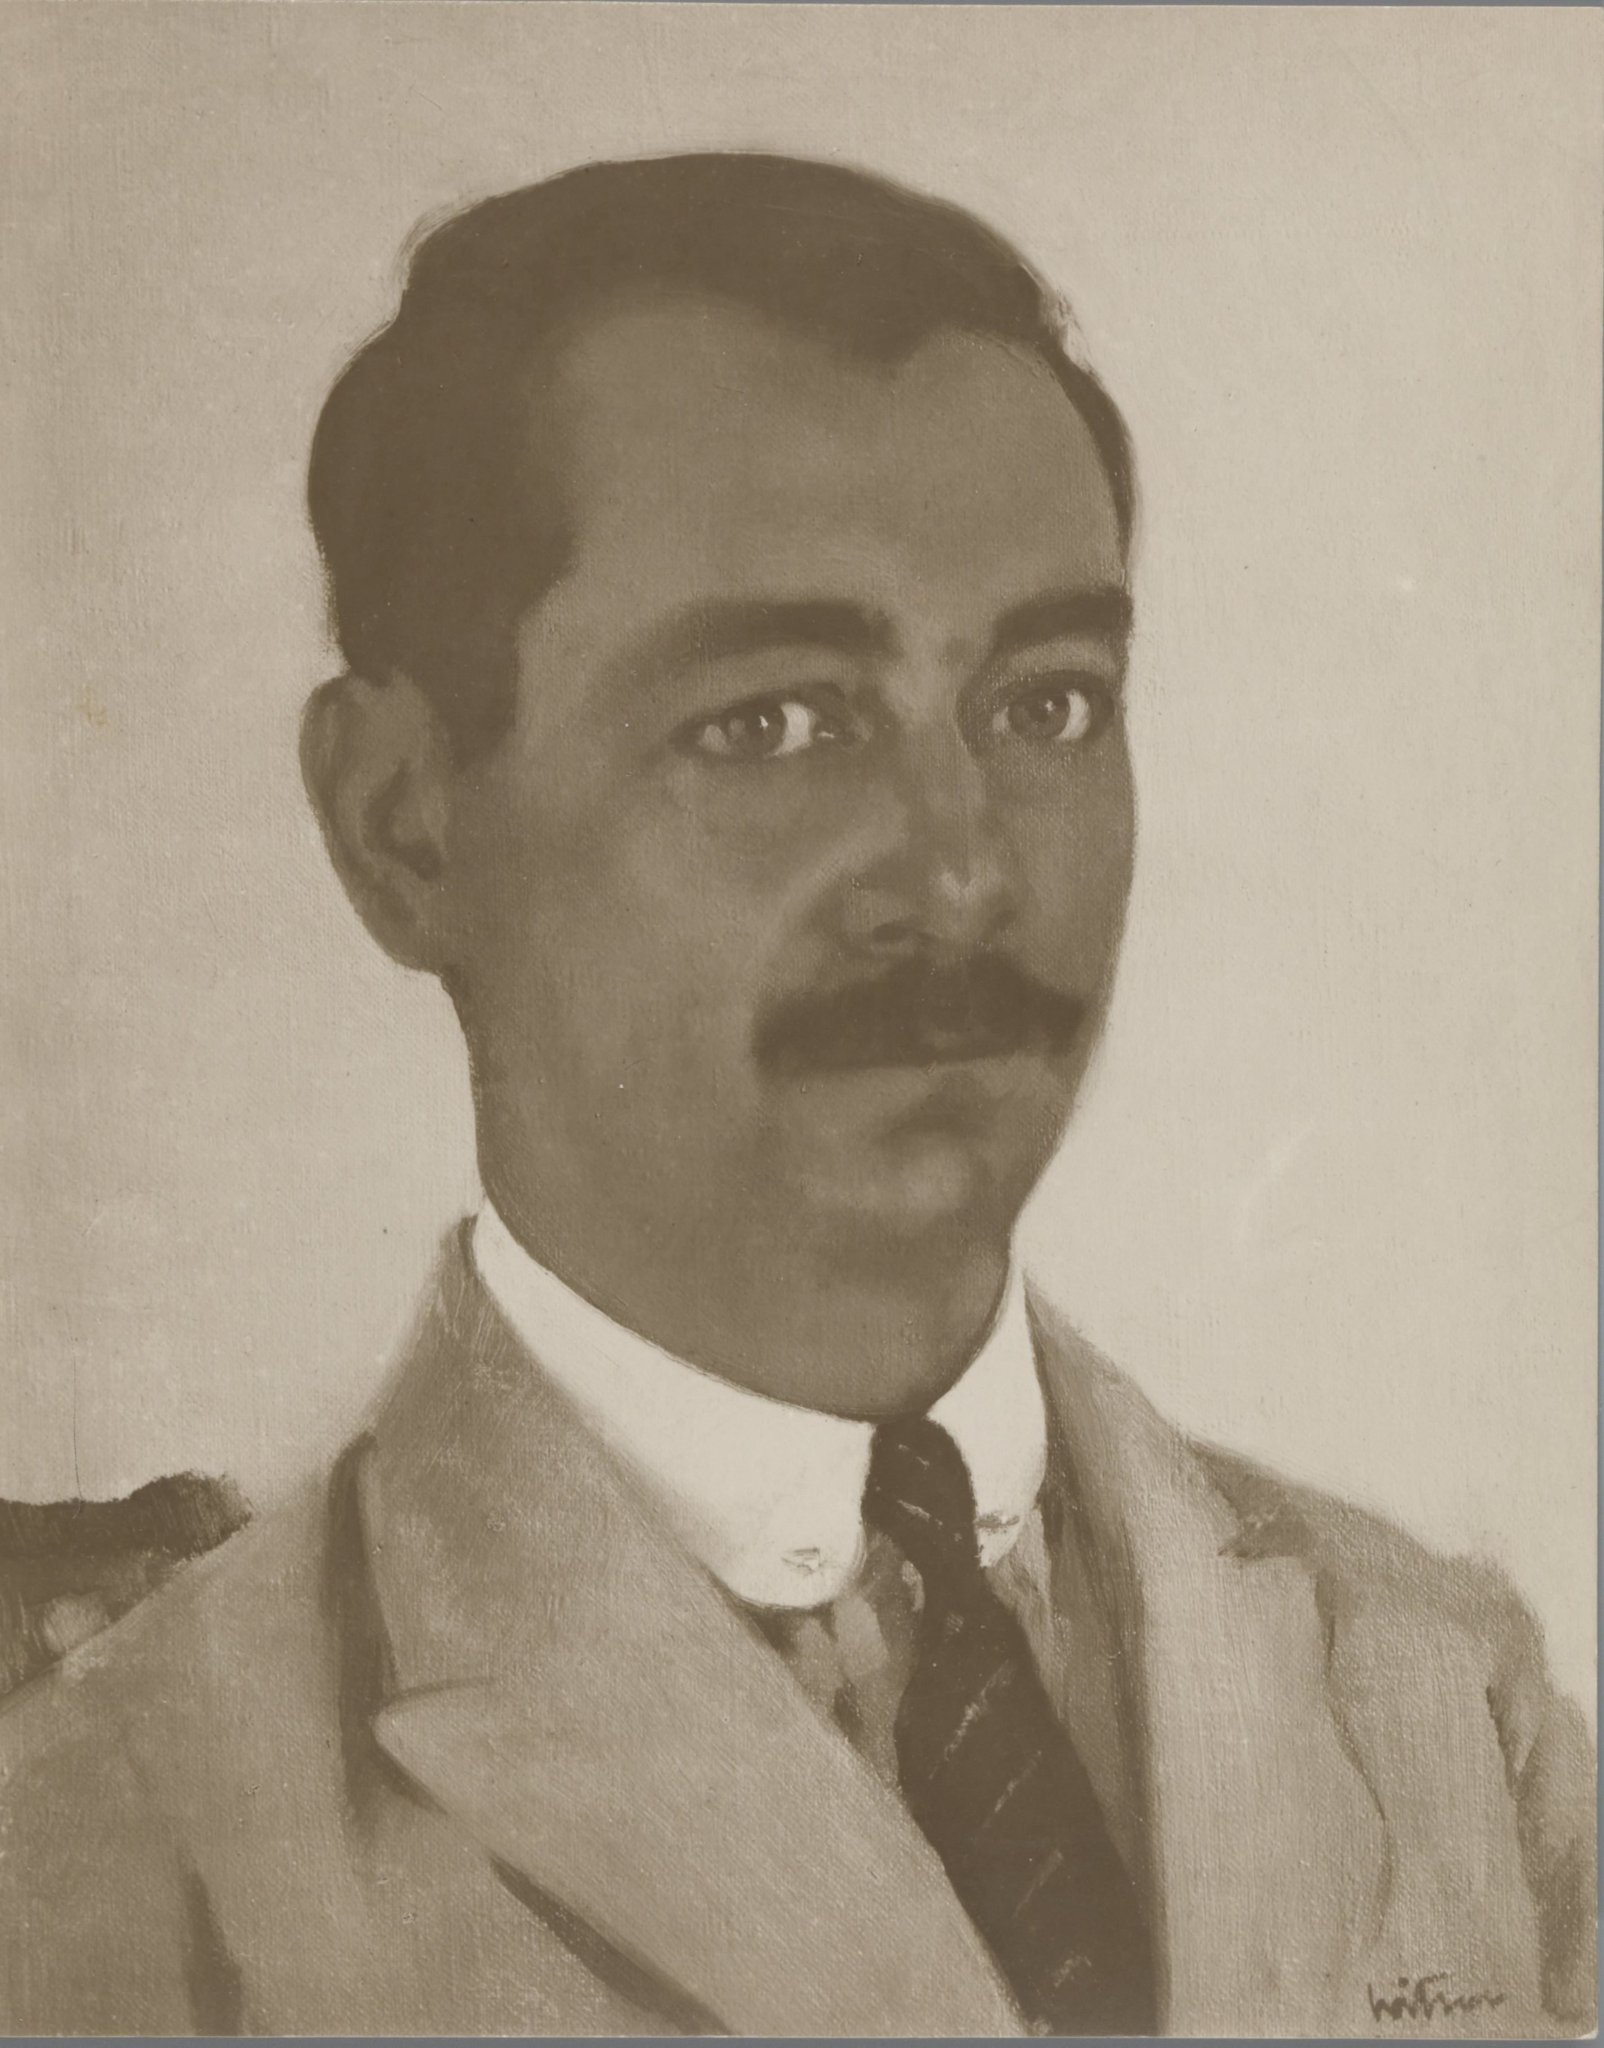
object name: photograph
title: Reproductie naar een foto, schilderij, tekening of prent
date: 1860-1915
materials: paper, photographic support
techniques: gelatin silver print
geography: netherlands